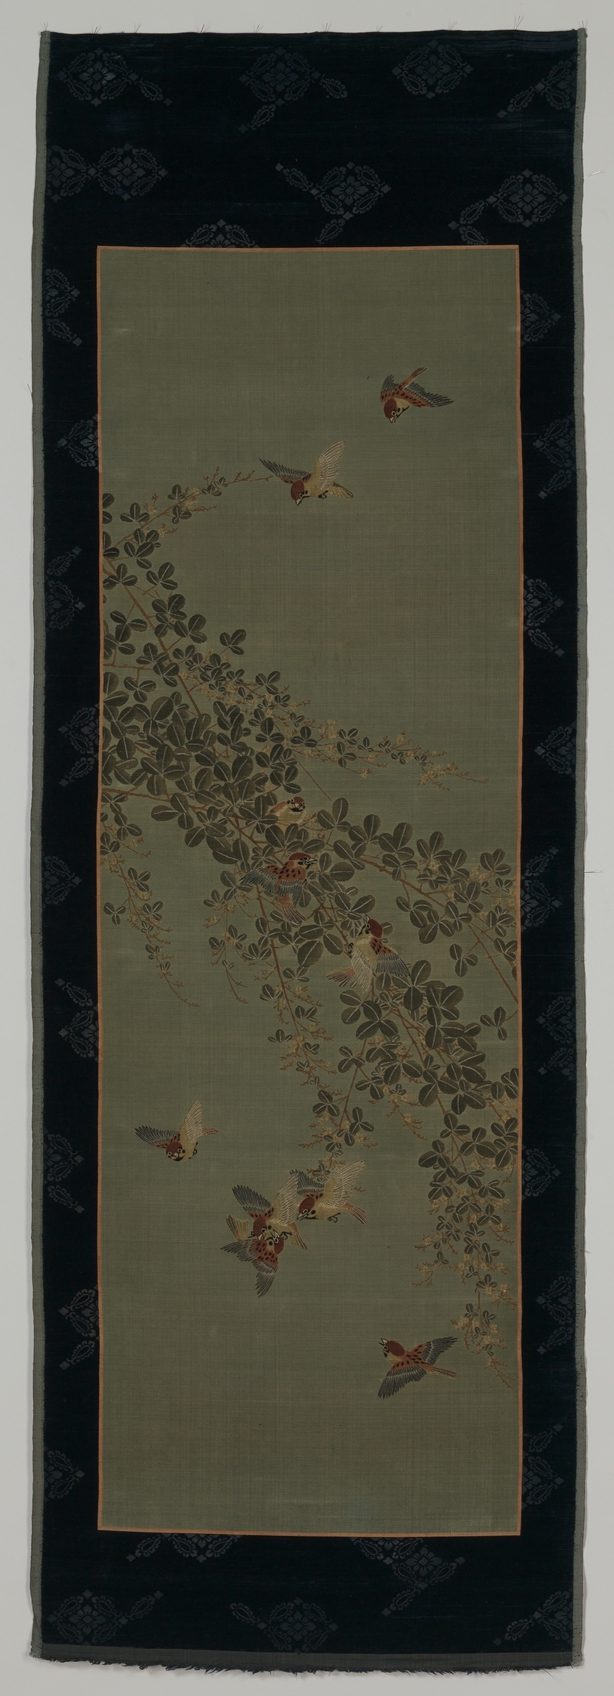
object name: panel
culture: japanese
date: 1767-1833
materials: silk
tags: birds